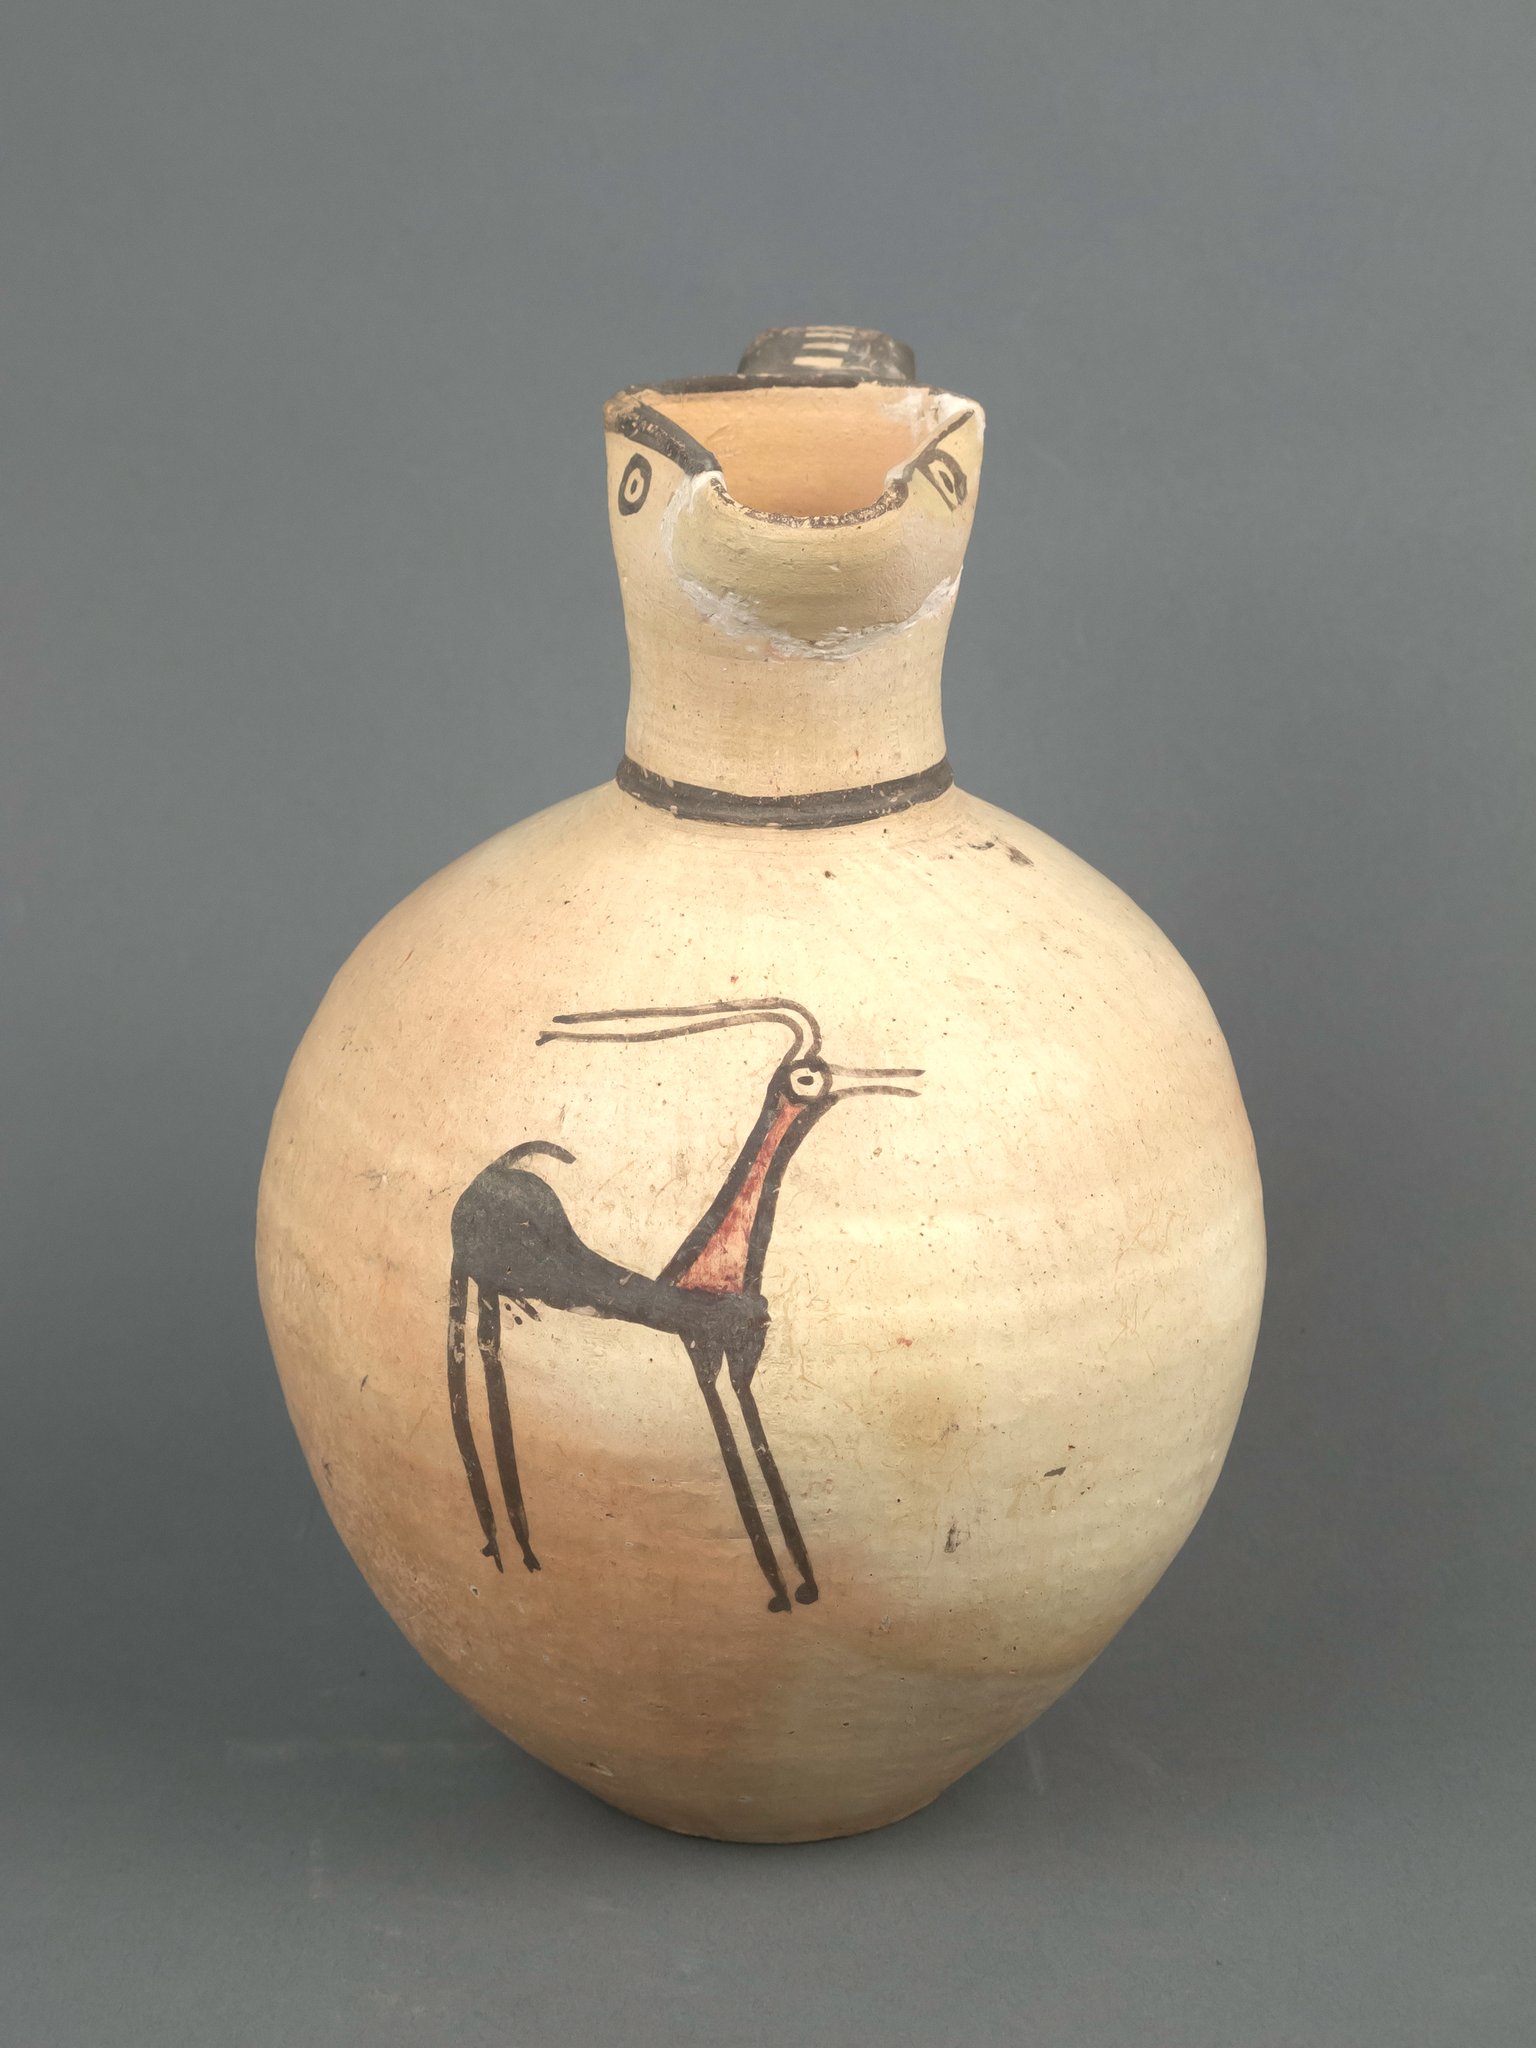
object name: jug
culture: cypriot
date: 850-750 BCE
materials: terracotta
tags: animals